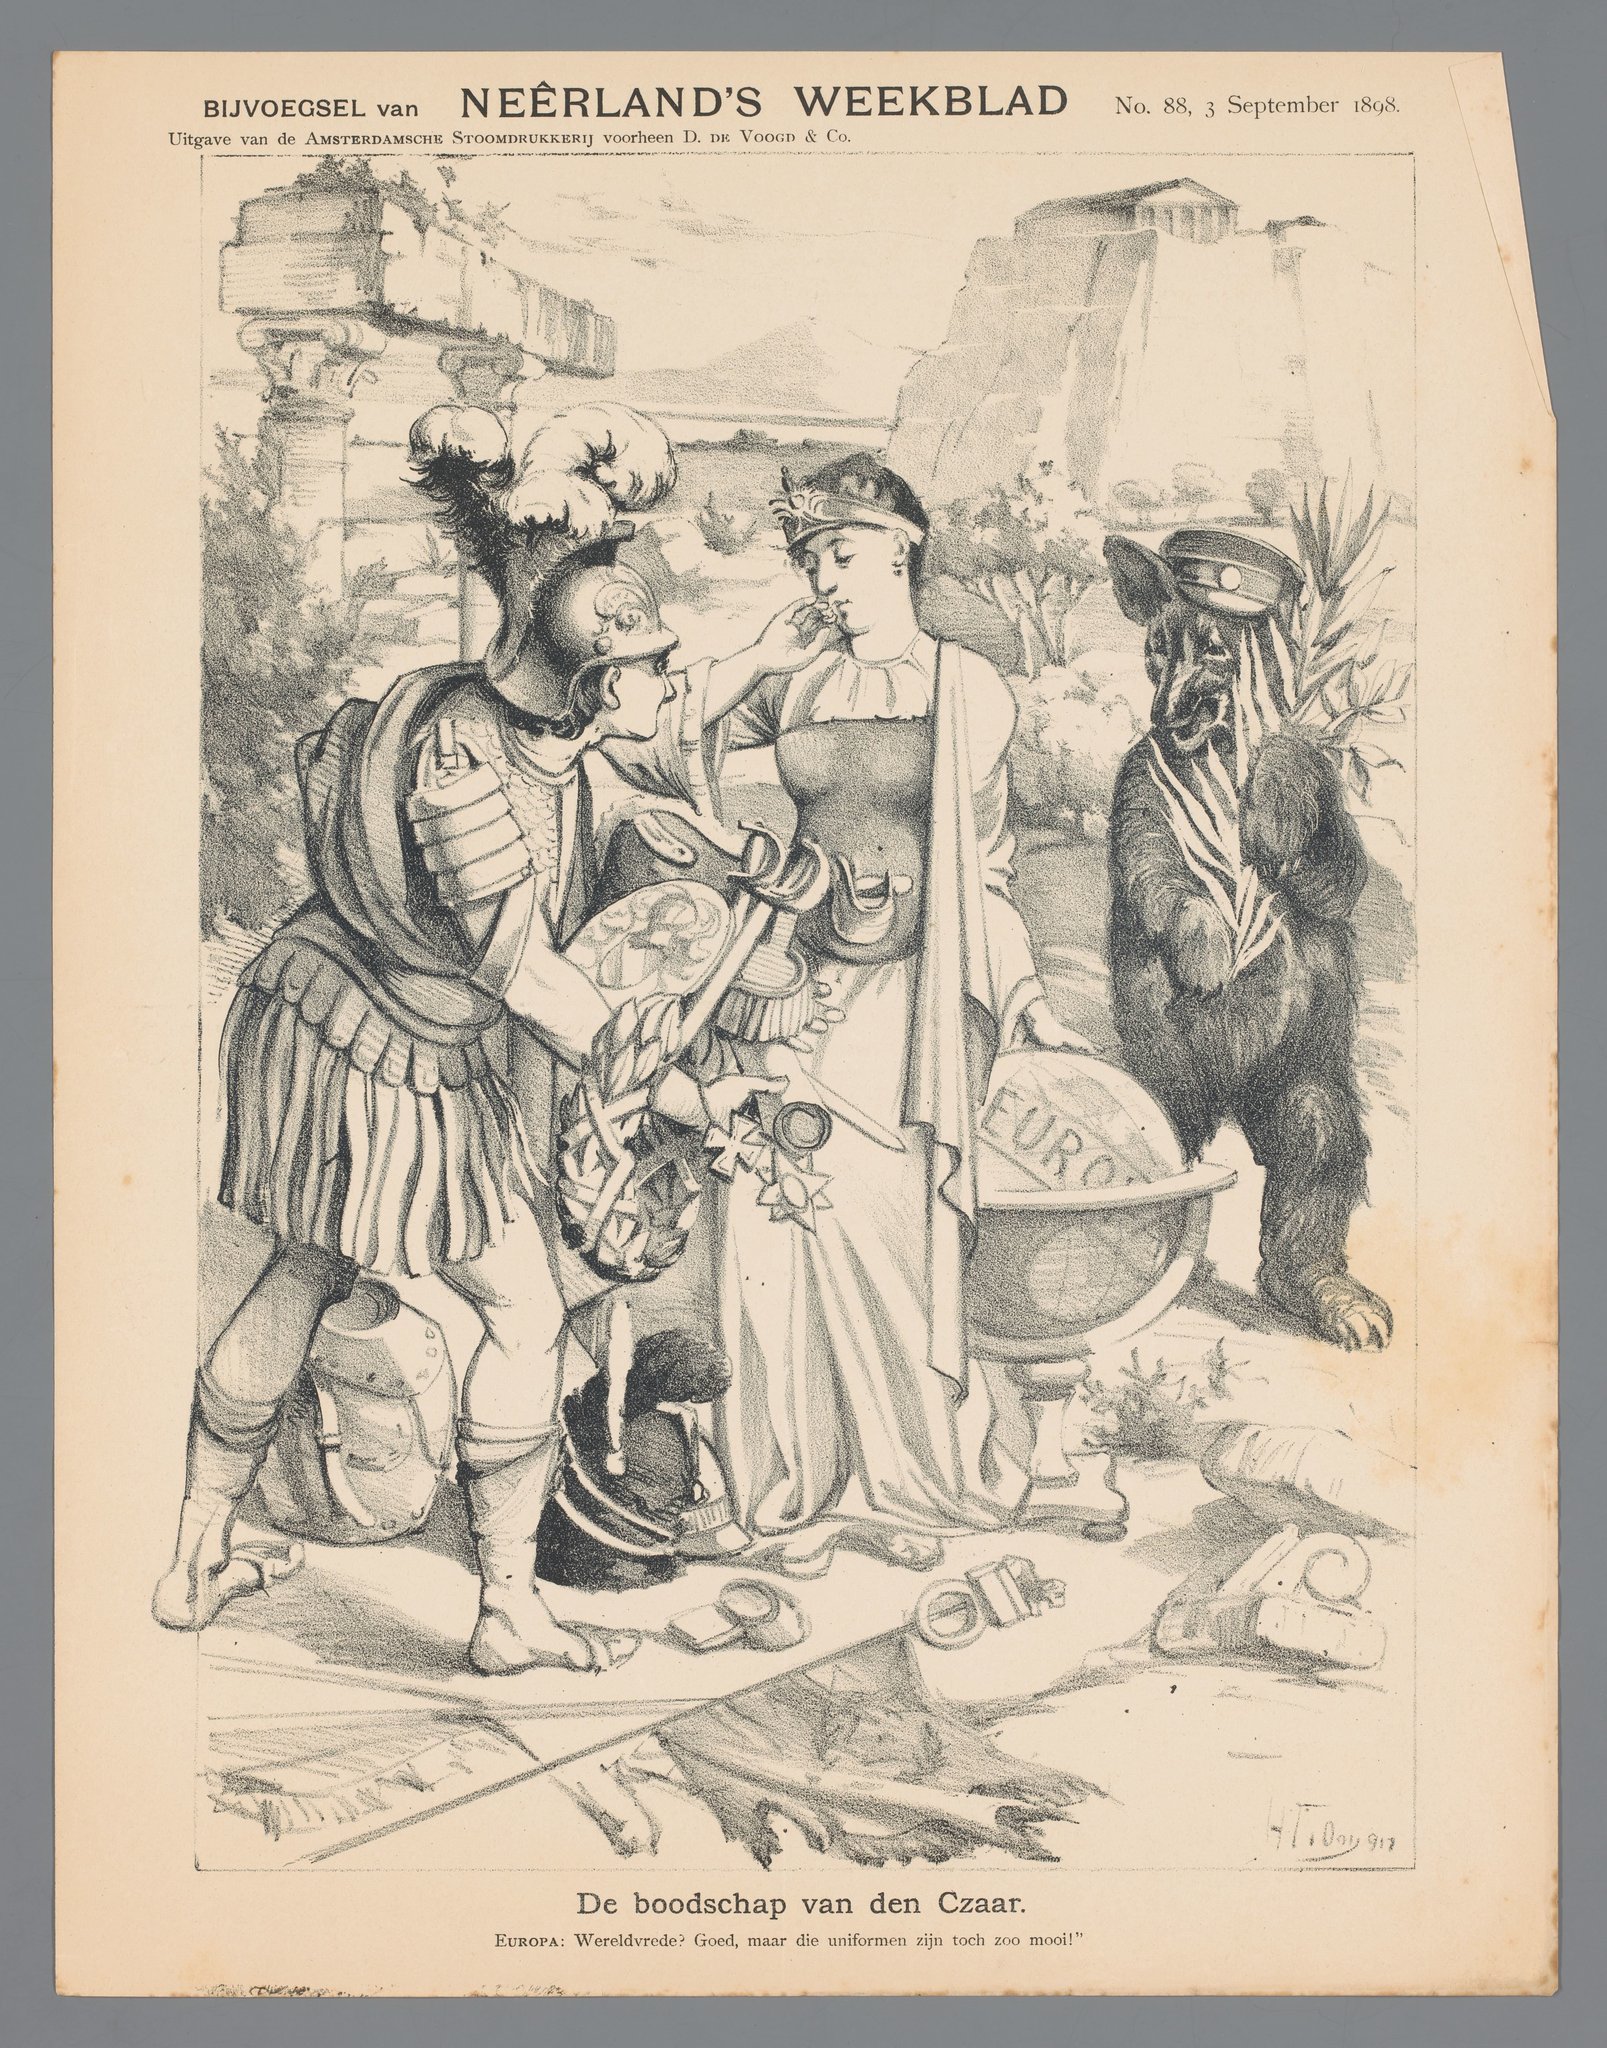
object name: cartoon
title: De boodschap van den Czaar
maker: h. van ooijen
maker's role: print maker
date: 1898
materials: paper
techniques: lithograph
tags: europe represented allegorically; 'europa' (ripa), personifications of countries, nations, states, districts, etc., peace, political caricatures and satires, russia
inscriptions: date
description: Prent uit het bijvoegsel van: Neêrland’s Weekblad, nr. 88, 3 september 1898.